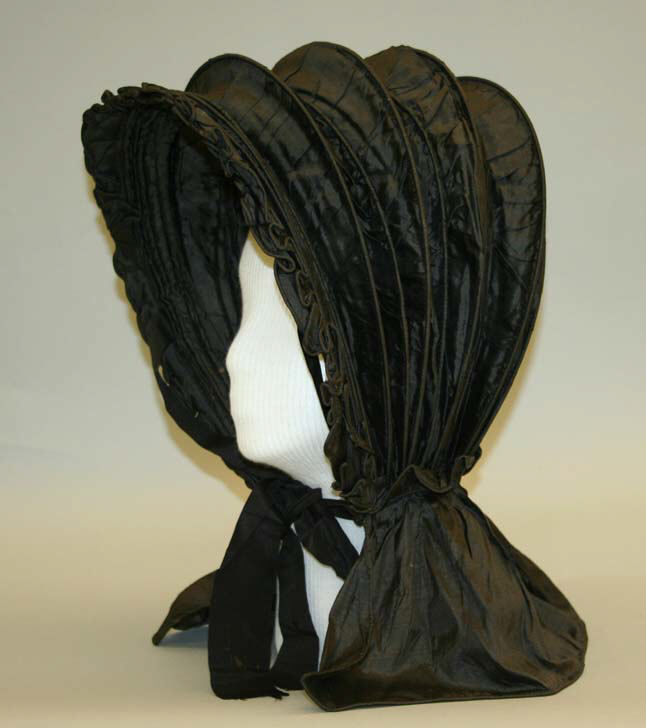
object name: calash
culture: american or european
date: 1701-1800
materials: silk